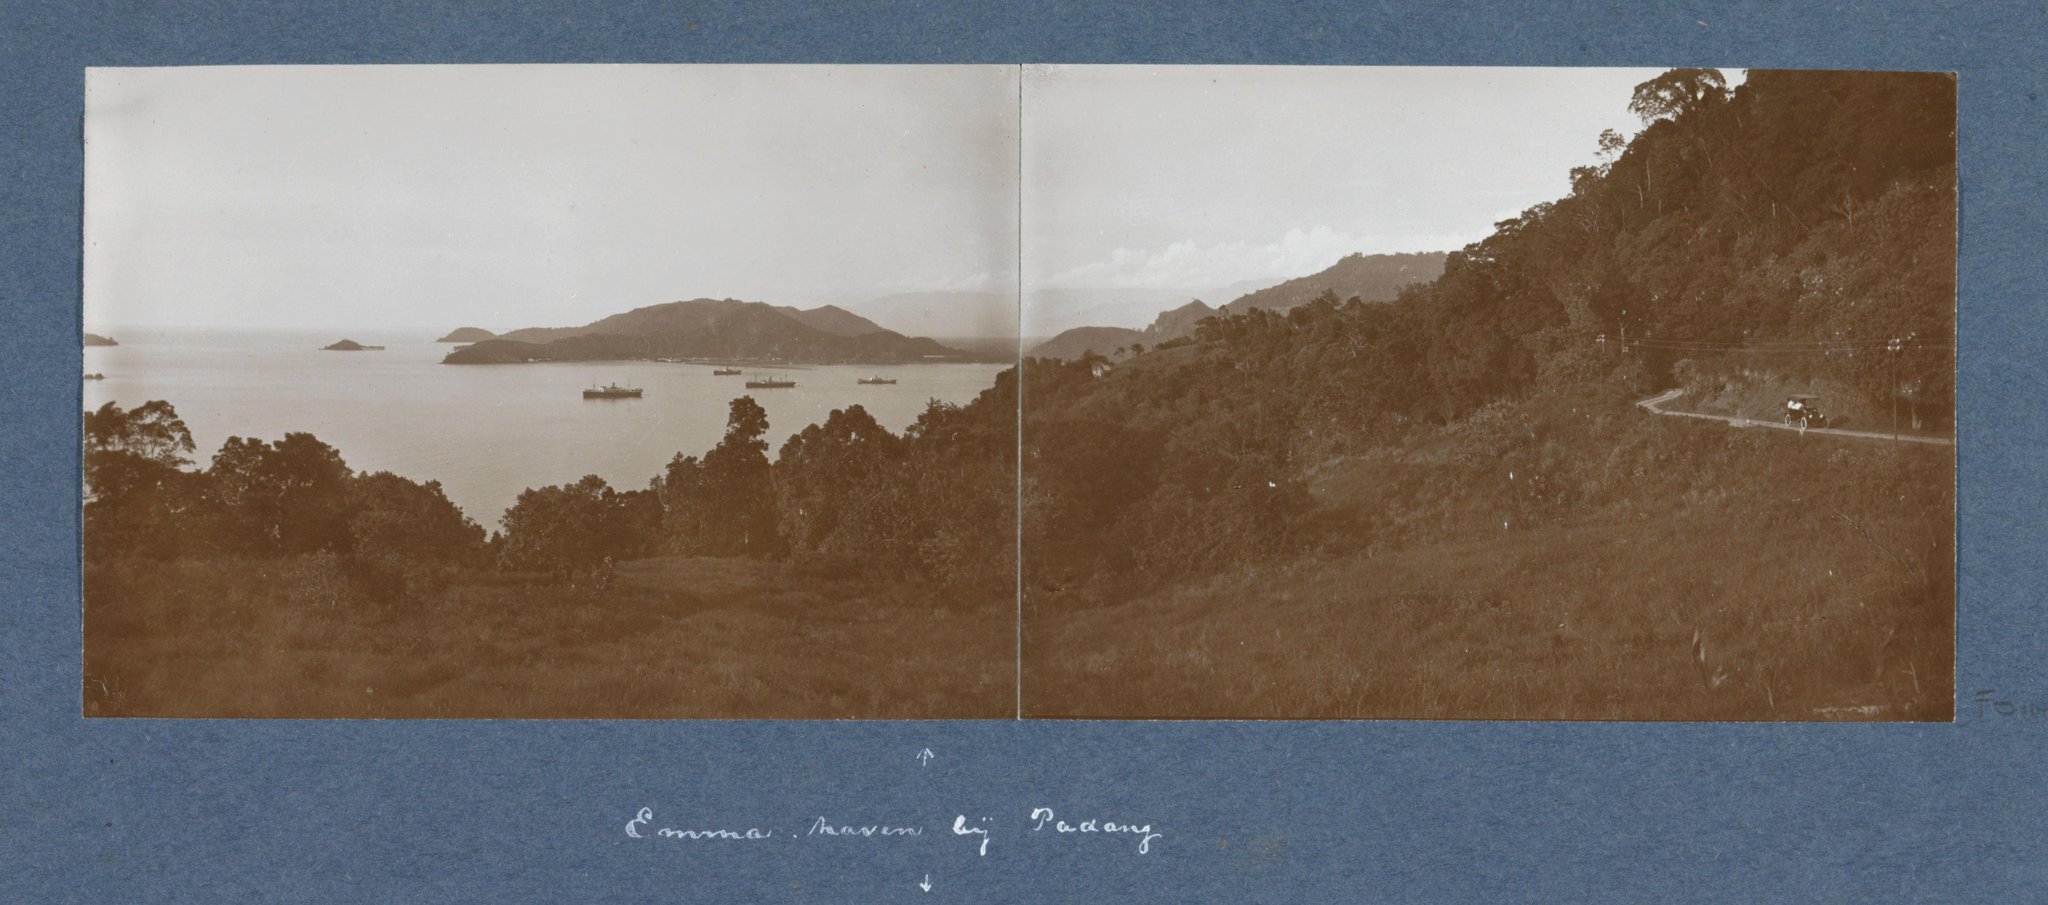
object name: album leaf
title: Schepen voor de Emmahaven van Padang, gezien vanuit het binnenland met rechts een auto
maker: Anonymous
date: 1900-1920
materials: paper, photographic support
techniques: gelatin silver print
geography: padang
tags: harbour (+ view ~ vehicle, ship, etc.), automobile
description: Panoramafoto bestaande uit twee afdrukken.